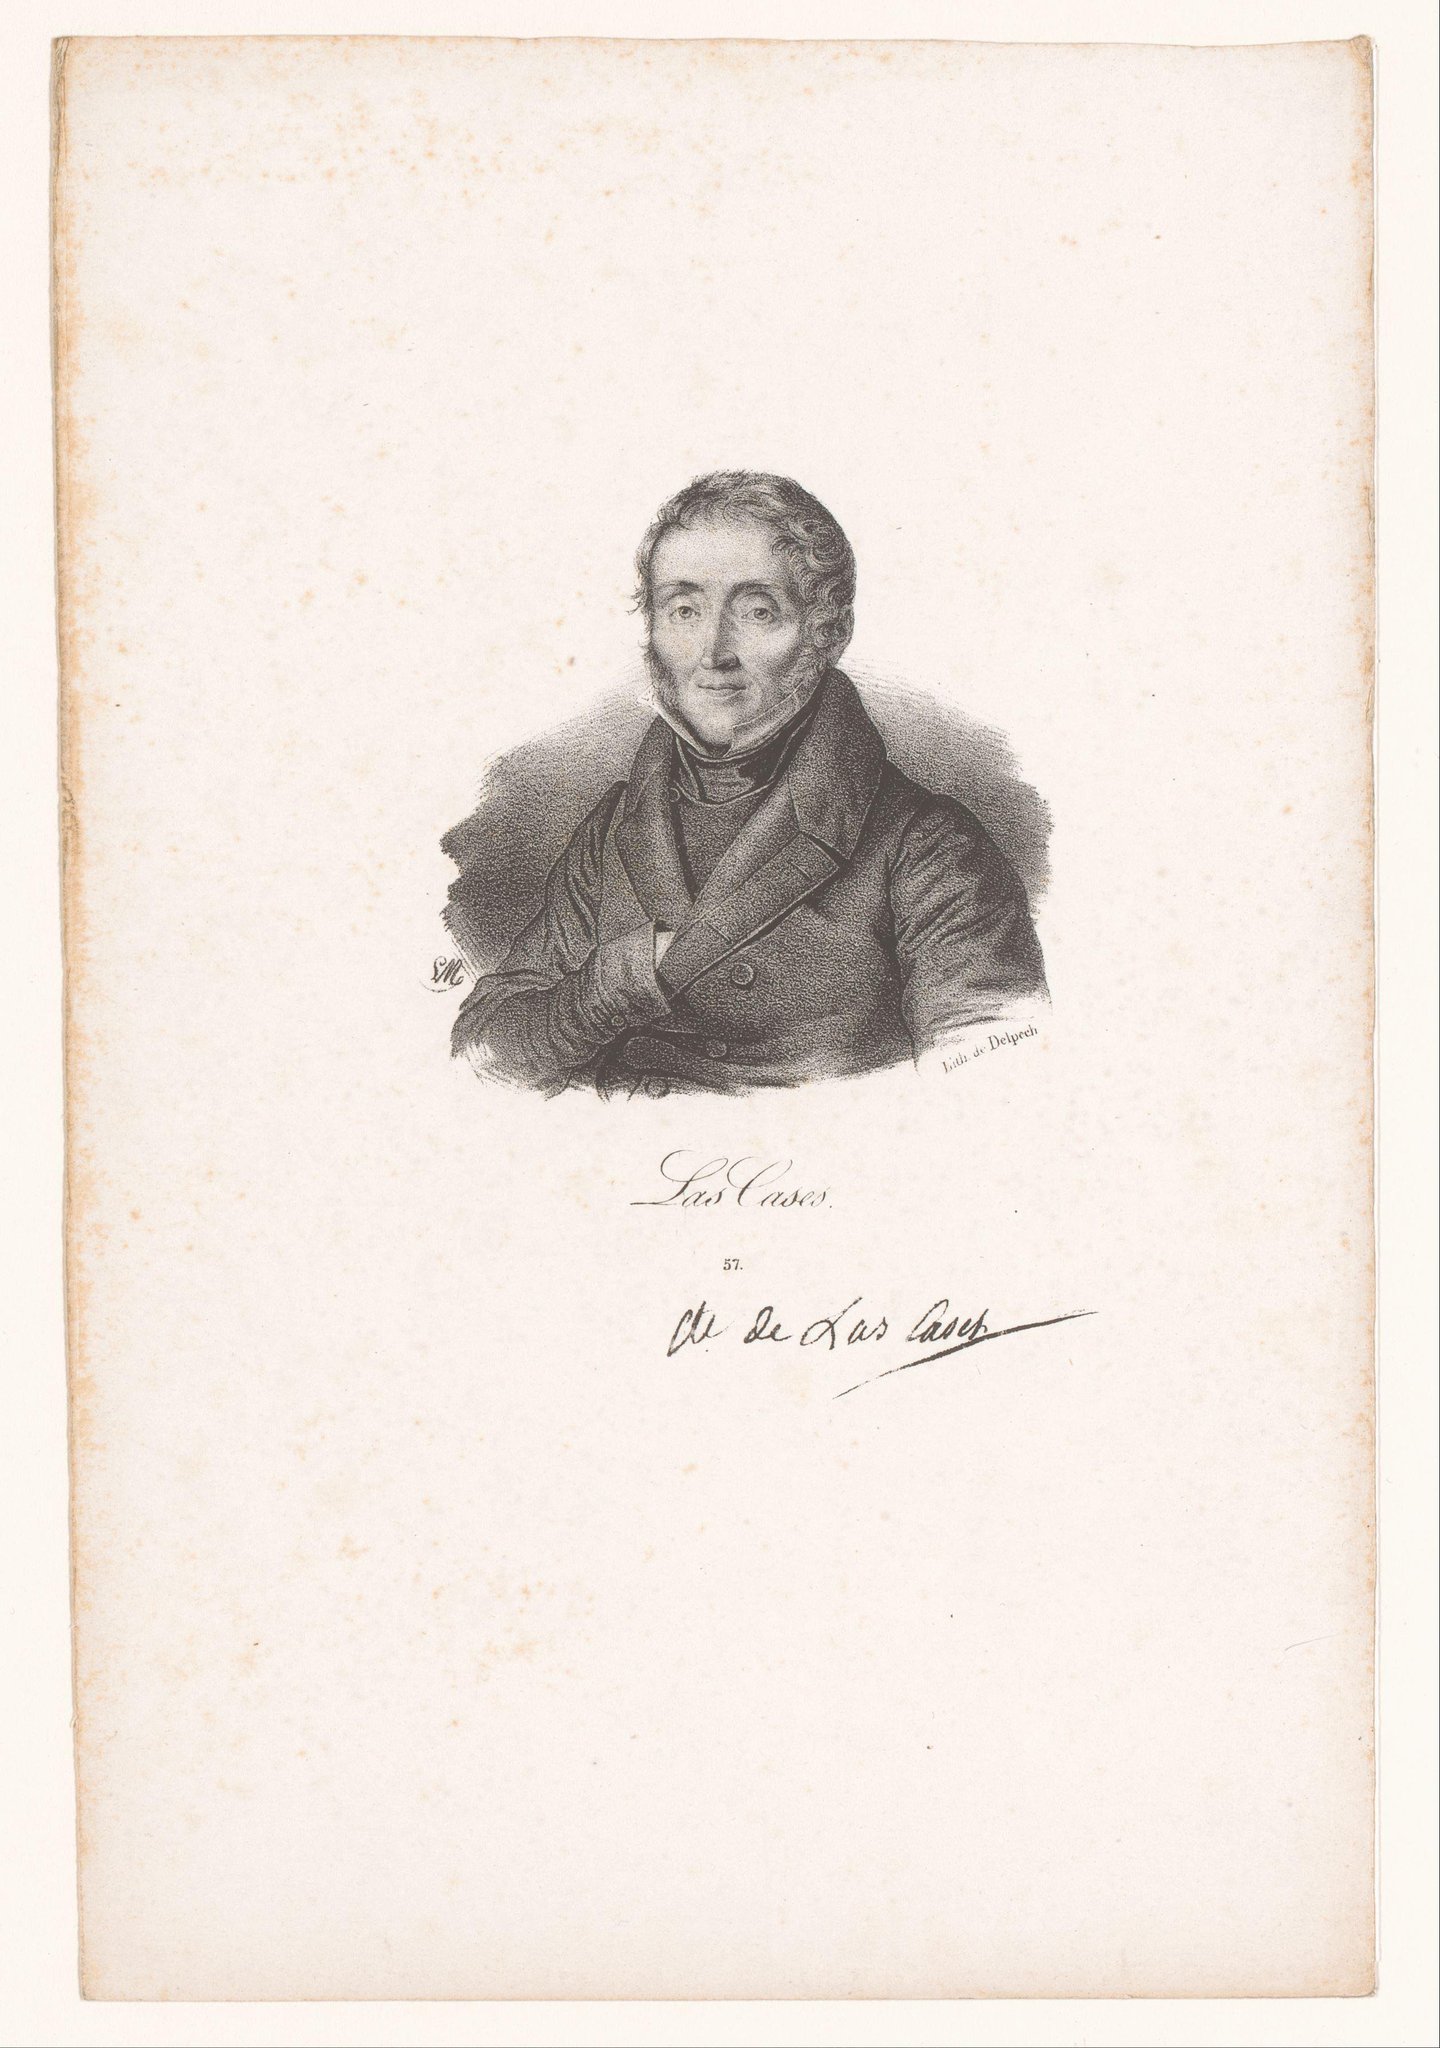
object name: print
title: Las Cases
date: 1825-1842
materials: paper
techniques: lithograph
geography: paris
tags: politician, historical persons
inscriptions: collector's mark: Lugt 2228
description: Prent waarschijnlijk gebruikt voor: Iconographie des contemporains ou Portraits des personnes dont les noms se rattachent plus particulièrement, soit par leurs actions, soit par leurs écrits, aux divers événements qui ont eu lieu en France, depuis 1789, jusqu'en 1829 (…). Parijs: veuve Delpech, 1832-1833. Mogelijk komt de prent ook voor in eerdere en/of latere publicaties uitgegeven door veuve Delpech of haar opvolger Rosselin.